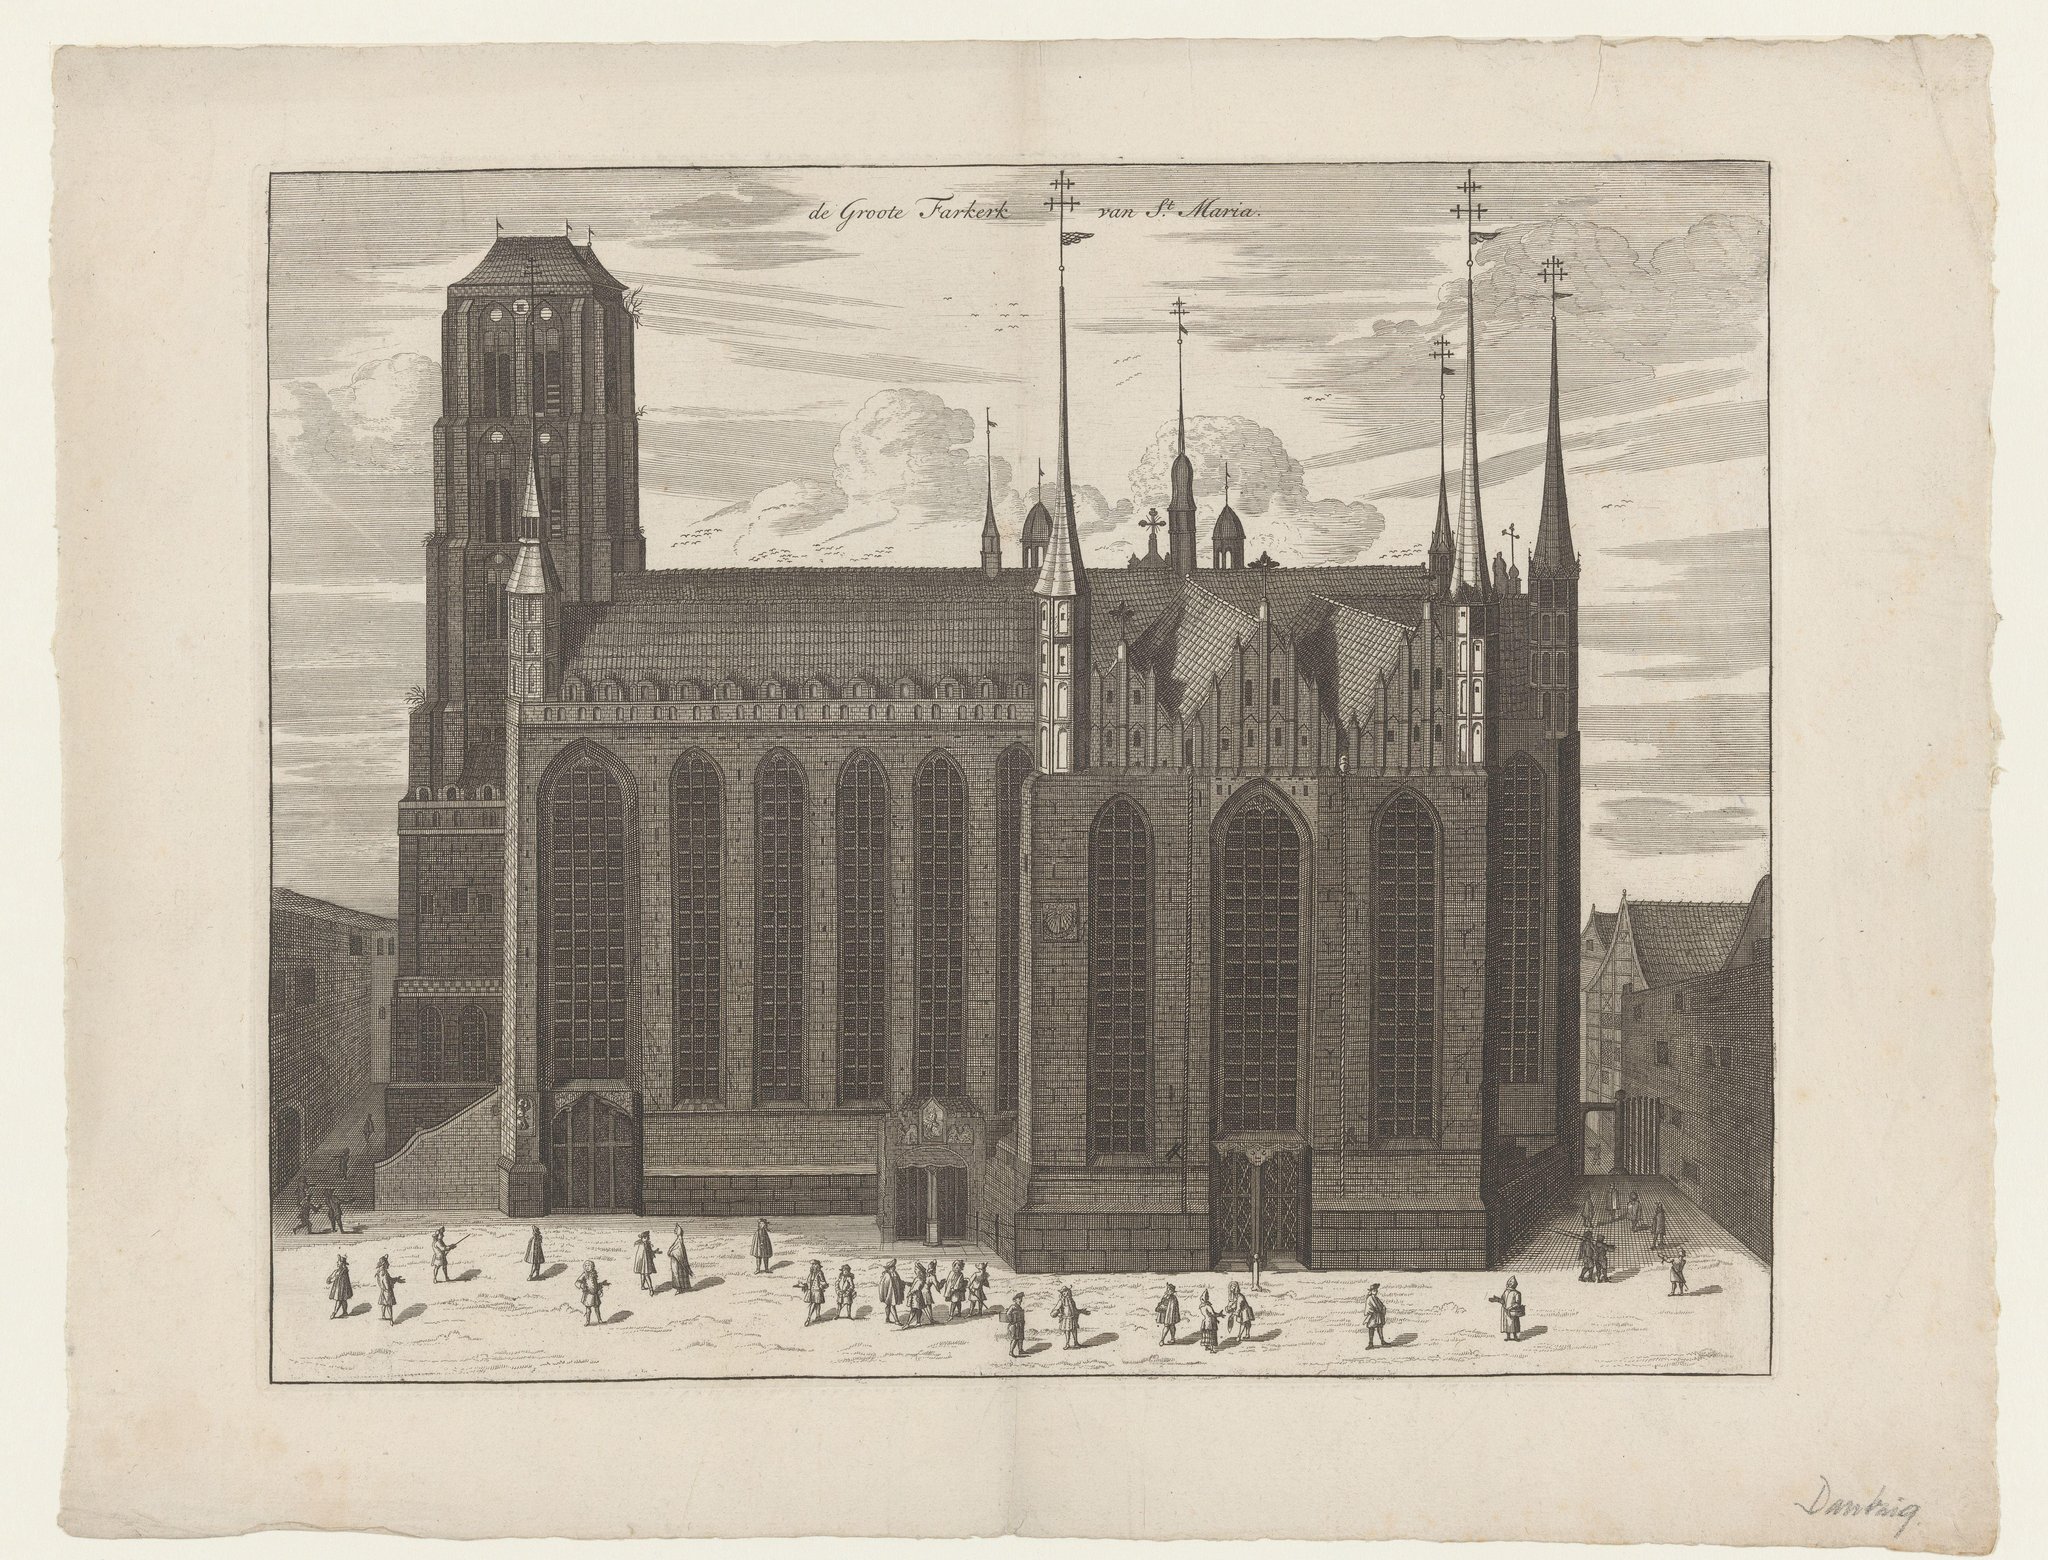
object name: print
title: Gezicht op de Mariakerk, te Gdansk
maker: Anonymous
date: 1735-1764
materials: paper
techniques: engraving, etching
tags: church (exterior)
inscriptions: collector's mark: Lugt 2228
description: Prent ook gebruikt in: Schuer, Jan Lodewyk. Beknopte beschryving van de stadt Dantzig. Amsterdam: Janssonius van Waesberge, 1735. En in: Schuer, Jan Lodewyk. Beknopte beschryving van de stadt Dantzig. Amsterdam: Hendrik Vieroot, 1764.